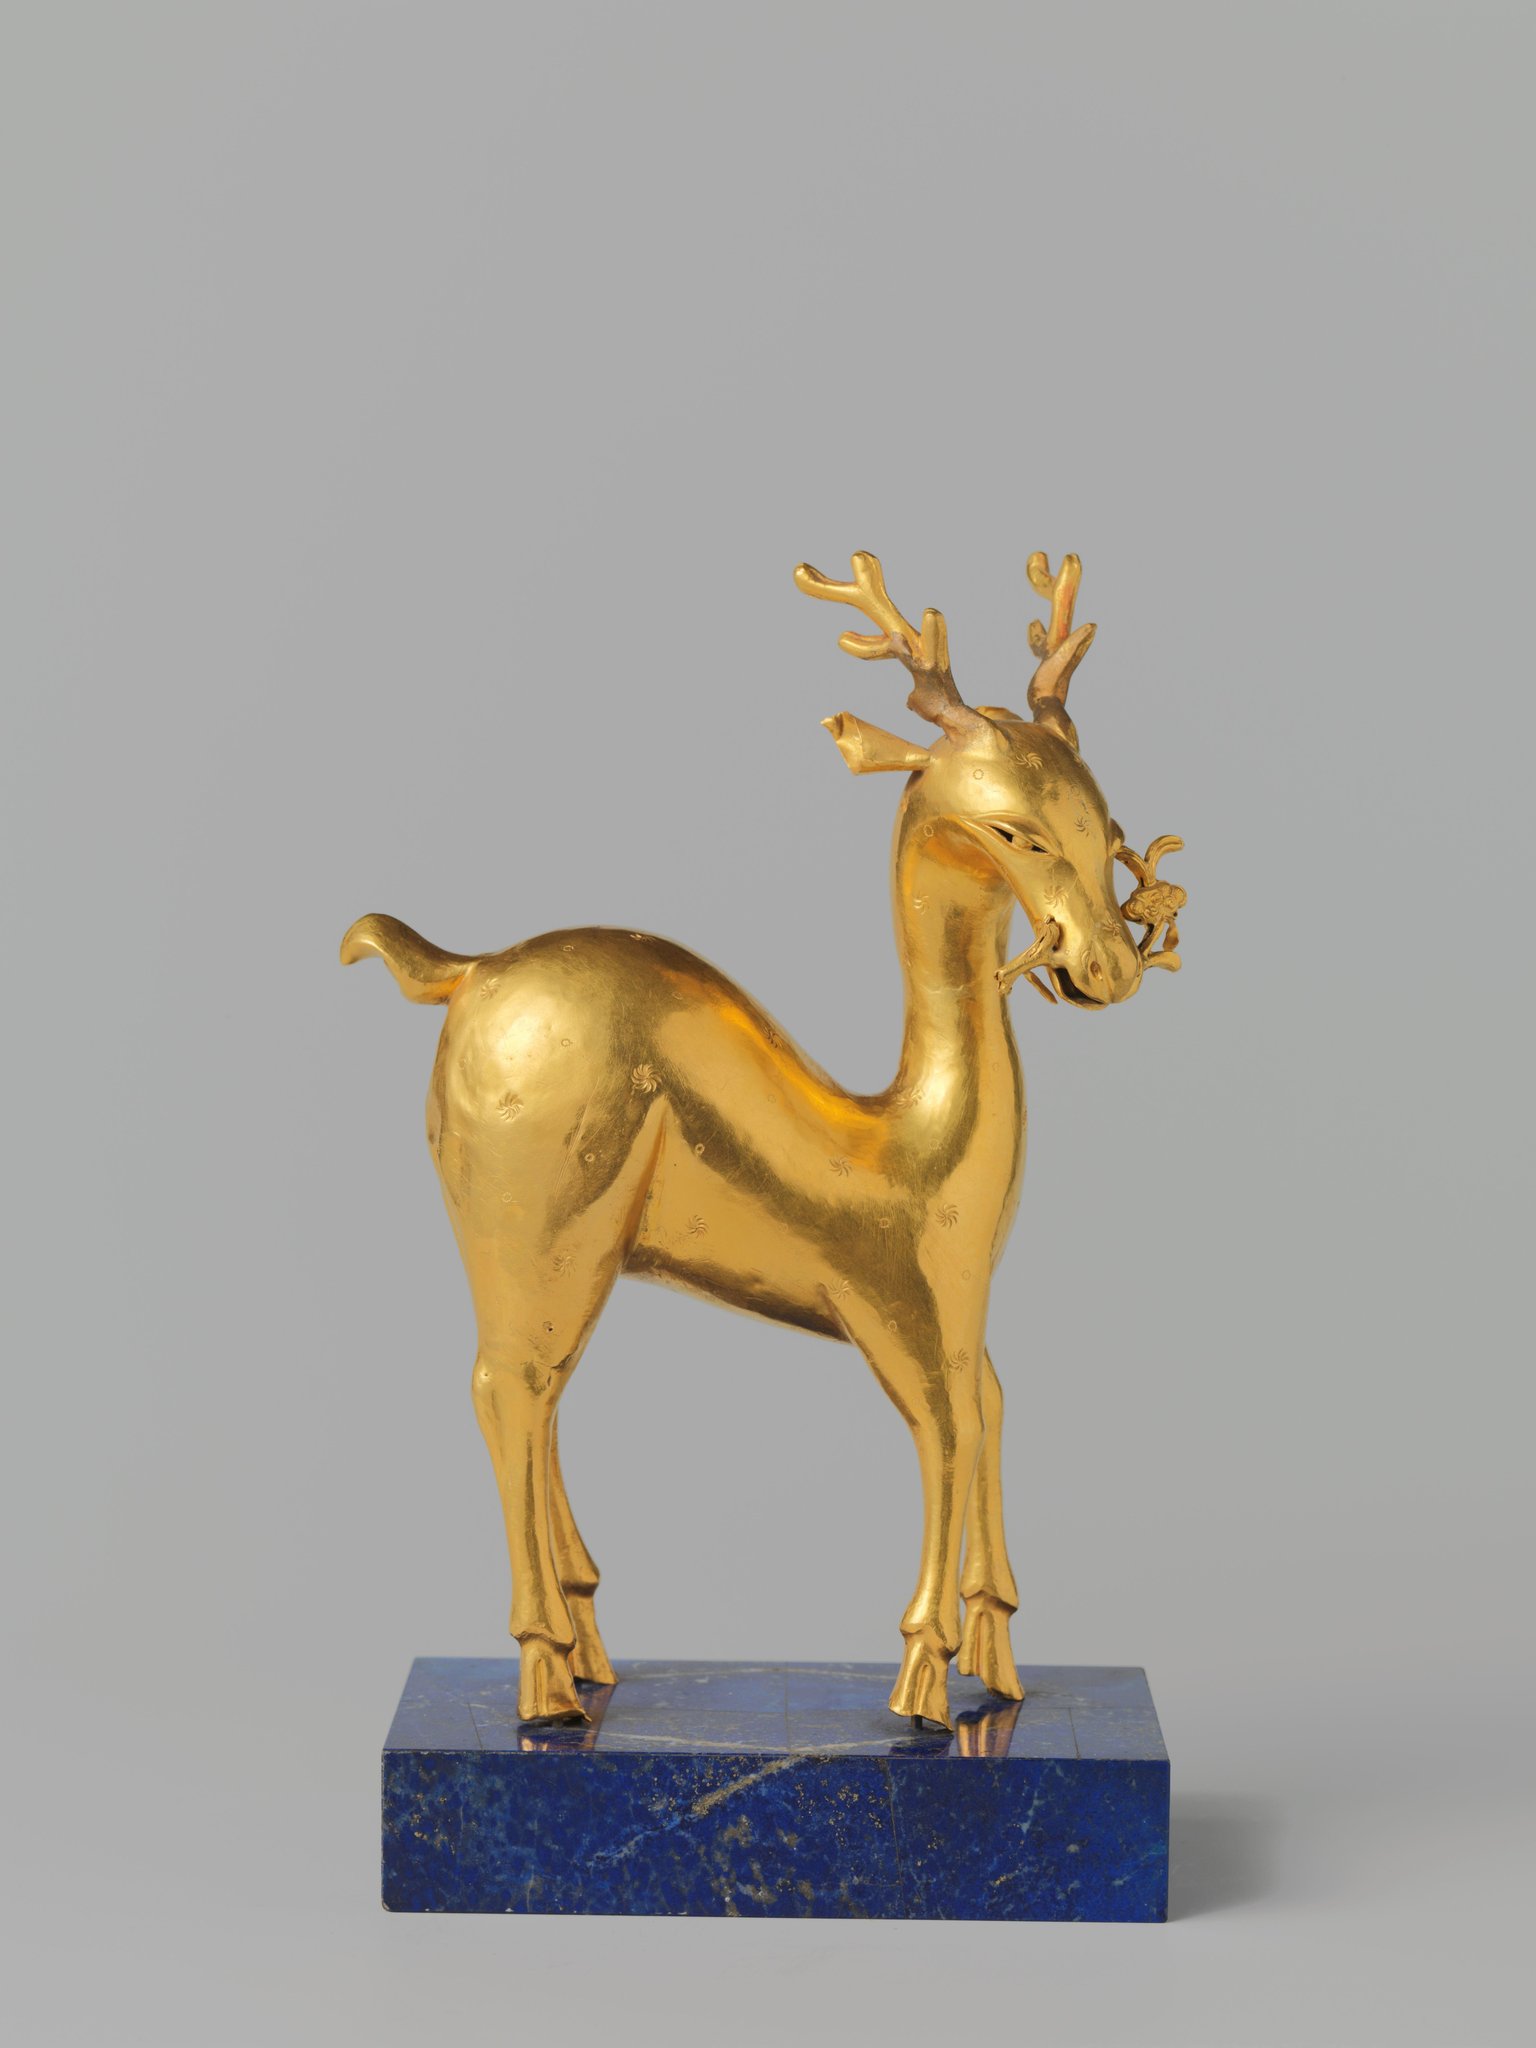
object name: dierfiguur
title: Gold deer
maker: Anonymous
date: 1700-1799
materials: lapis lazuli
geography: china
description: Voetstuk van lapis lazuli, van dierenfiguur van goud.